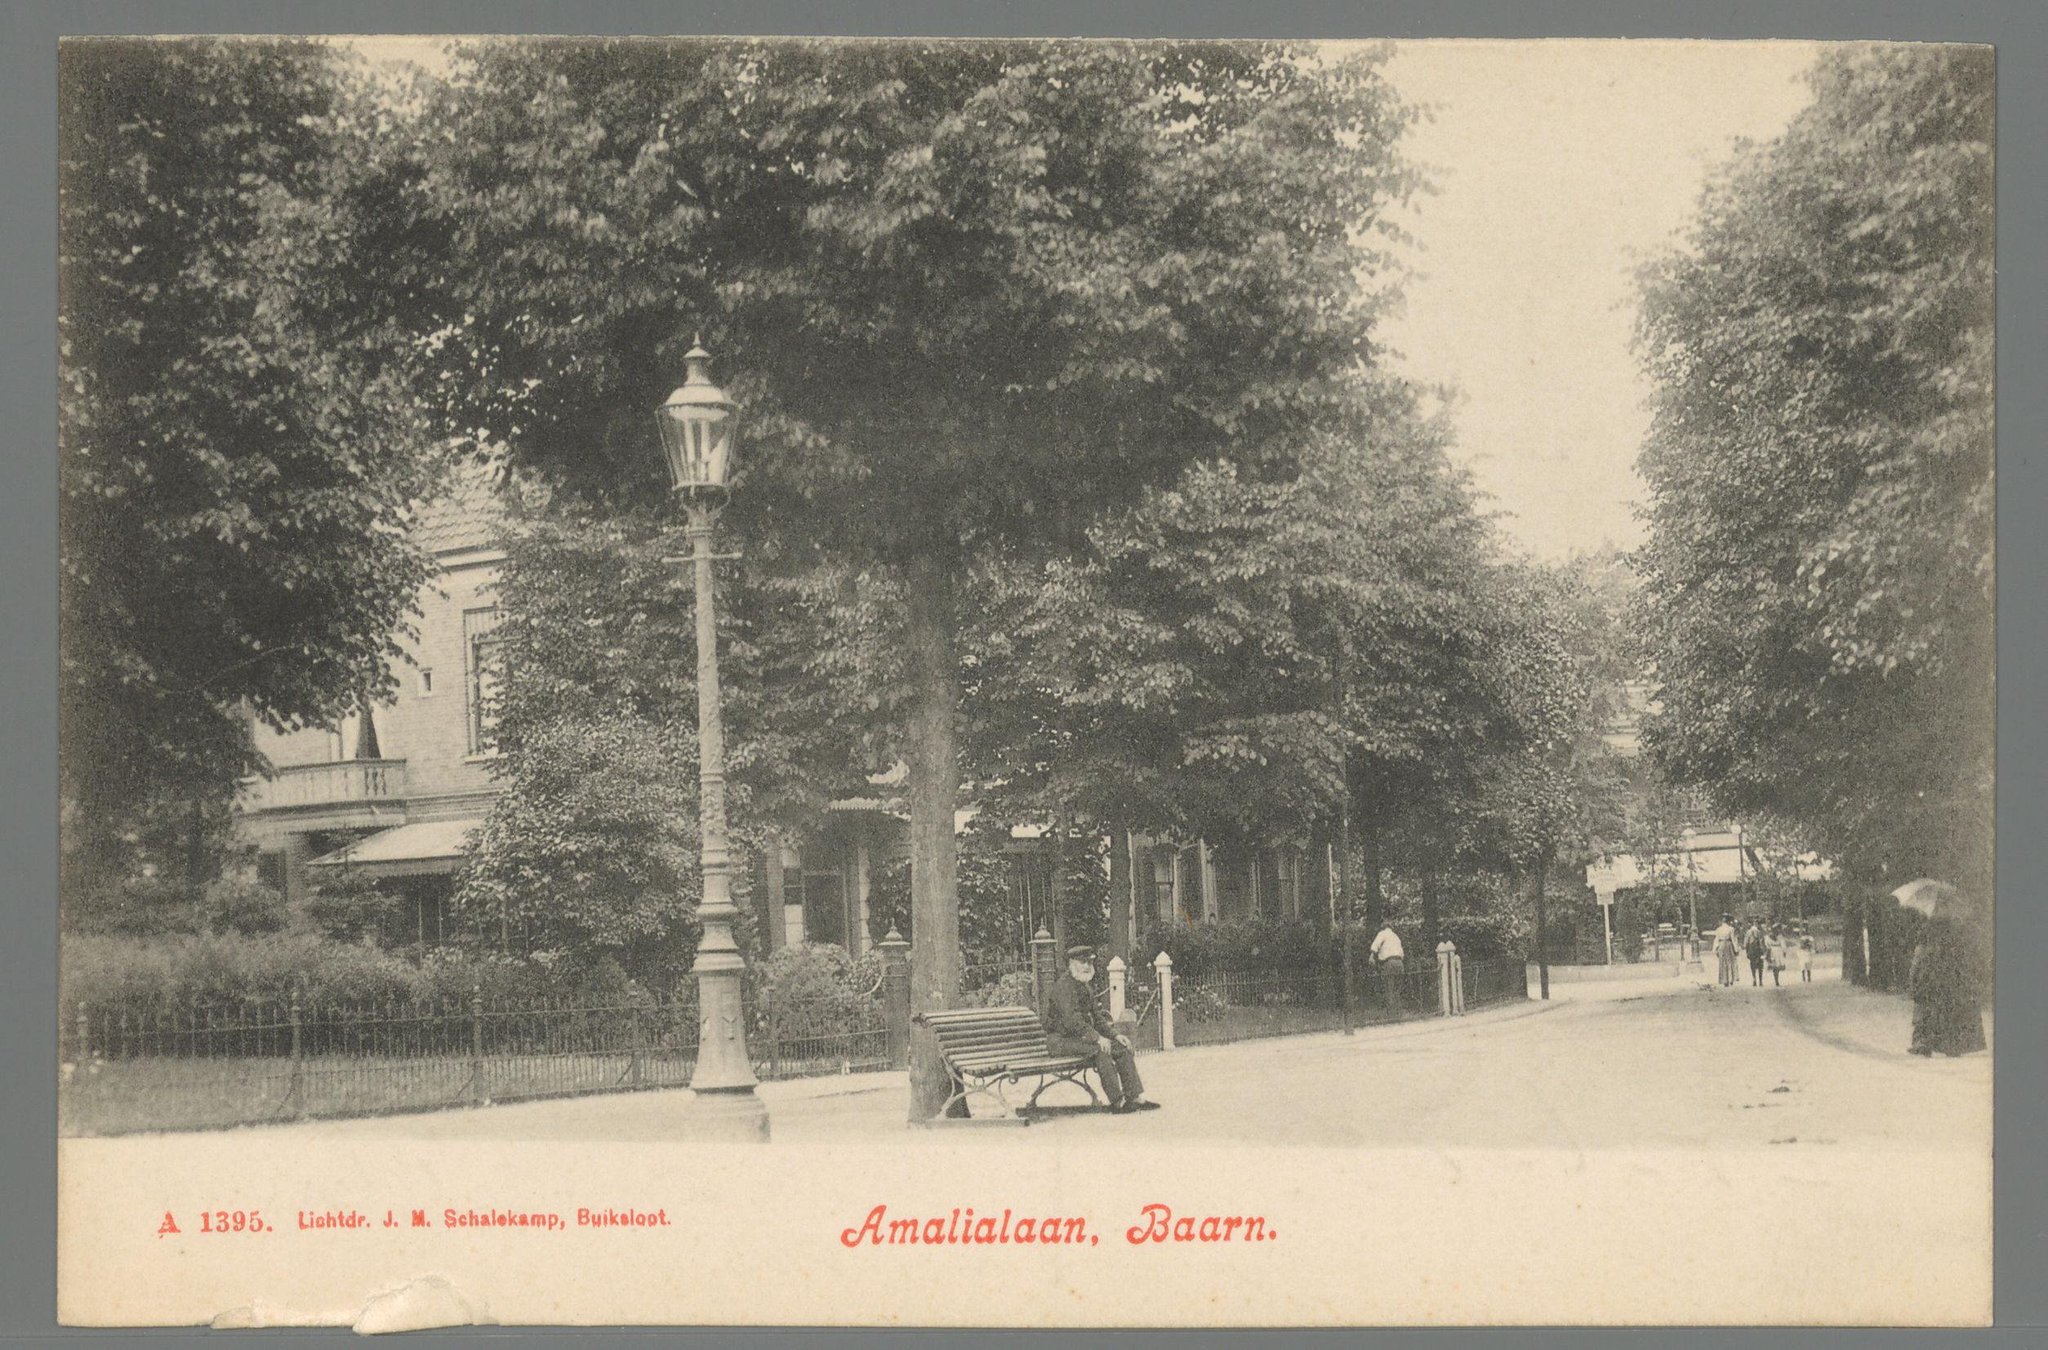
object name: photomechanical print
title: Amalialaan, Baarn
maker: johan marinus schalekamp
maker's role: publisher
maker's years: 1844-1912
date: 1897-1908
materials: cardboard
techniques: photograph, writing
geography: buiksloot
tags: street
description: Vermoedelijk is deze prentbriefkaart oorspronkelijk gedrukt in de periode 1897-1905 en zijn op verso later een deelstreep en lijnen voor het adres bijgedrukt, zodat de kaart na 1905 alsnog geldig was en verkocht kon worden.